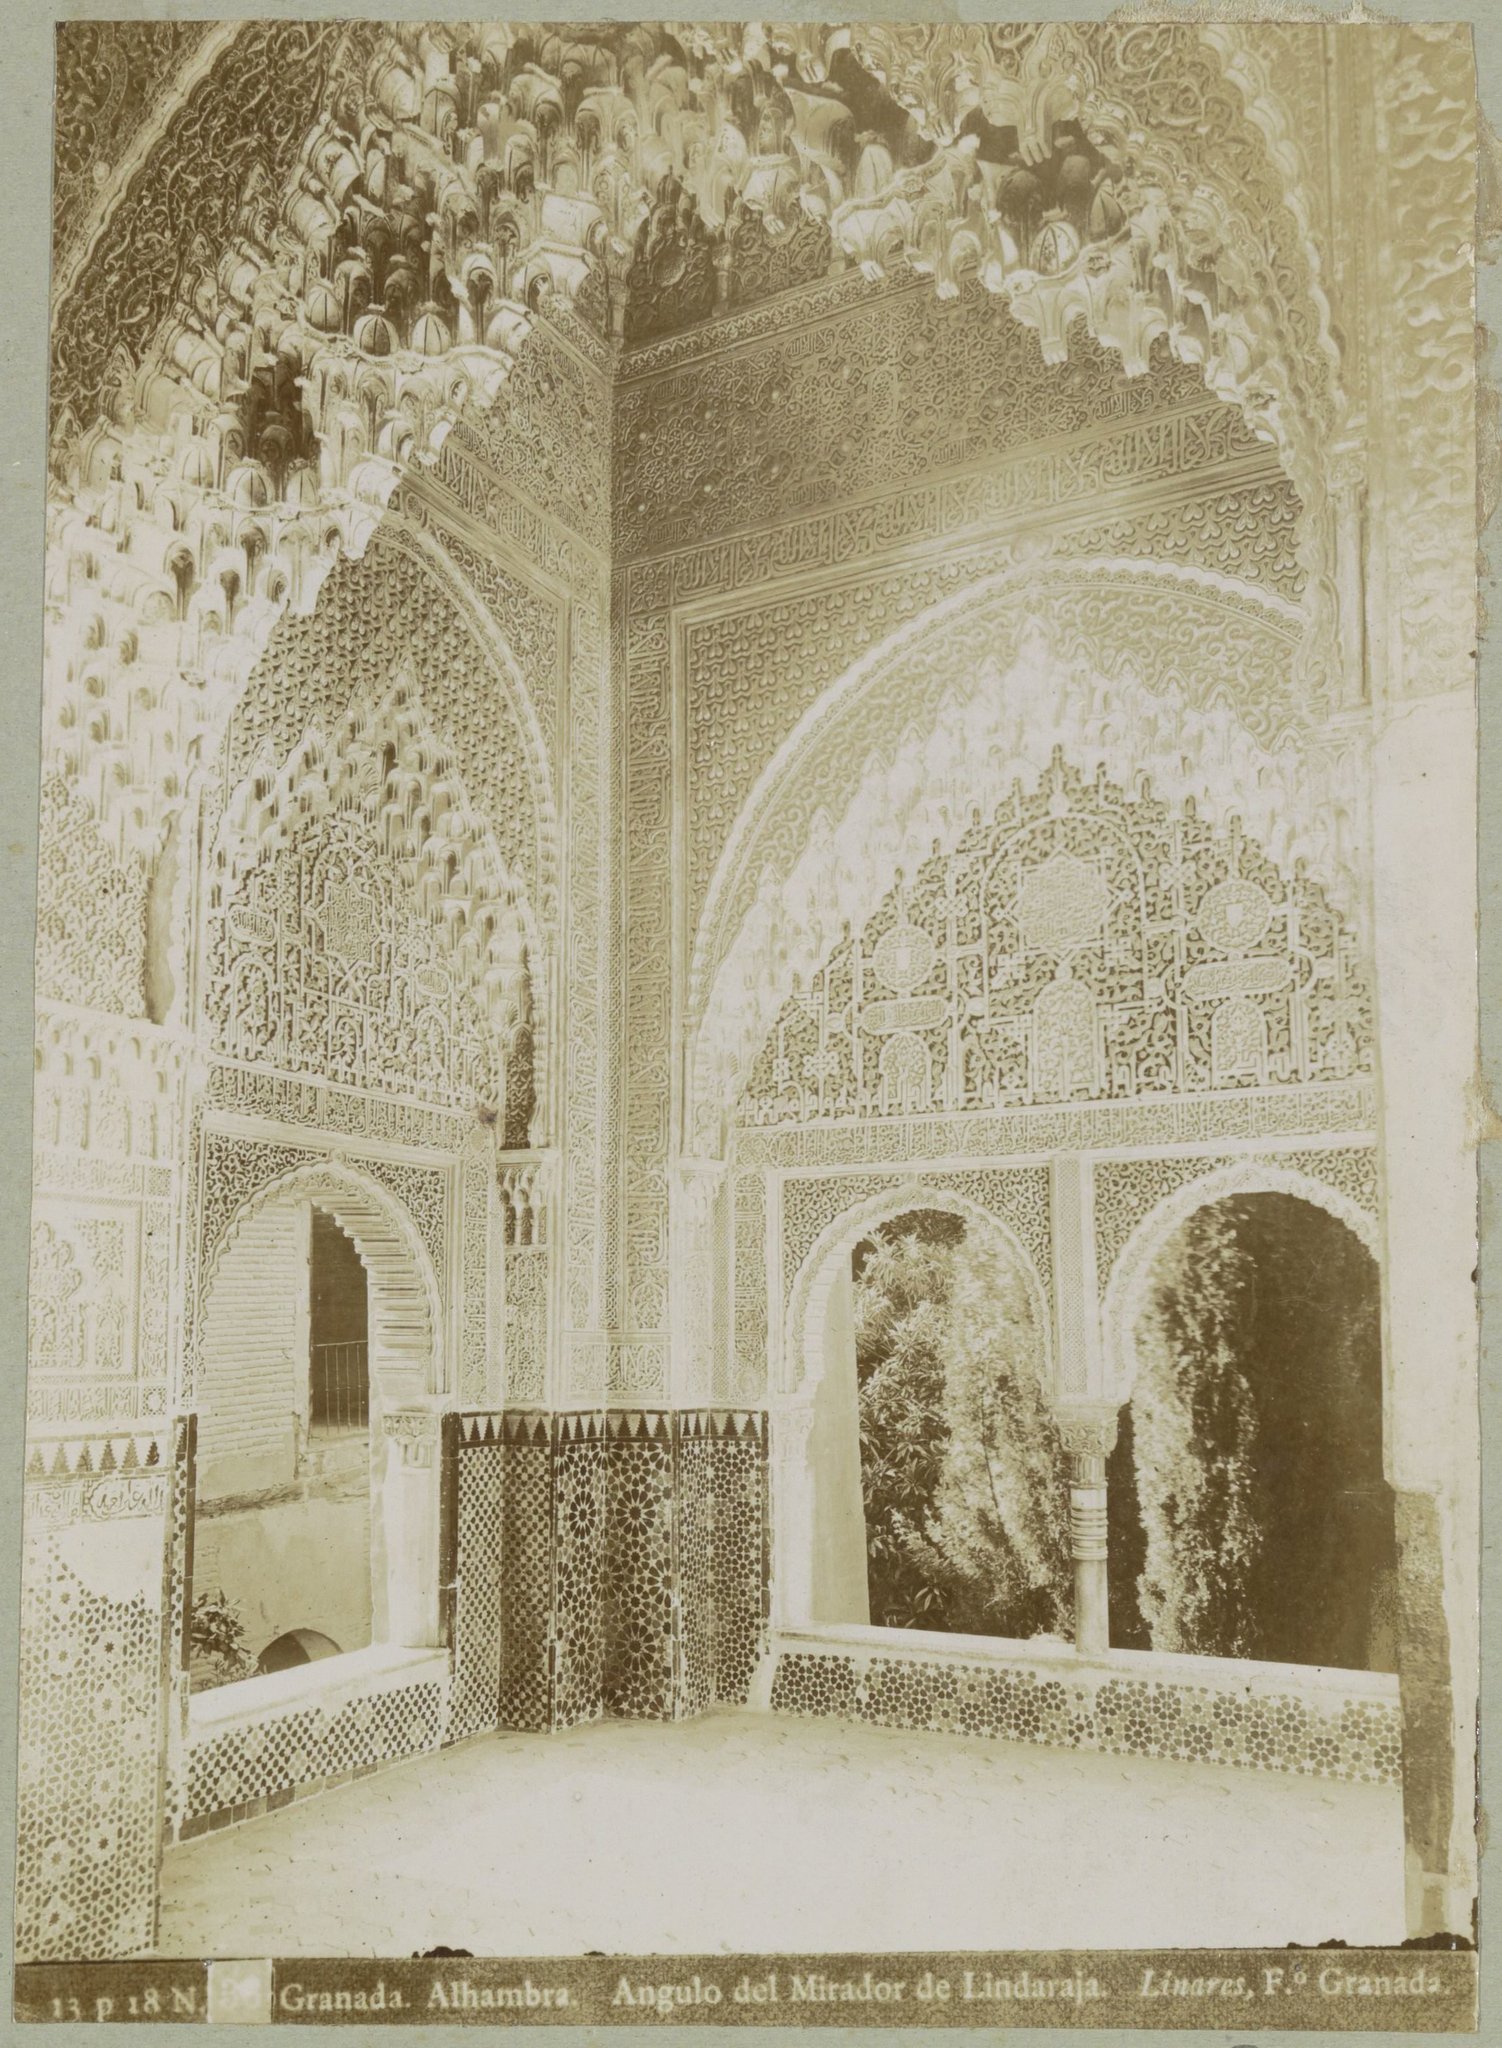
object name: photograph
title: Angulo del Mirador de Lindaraja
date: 1860-1900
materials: photographic support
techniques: daylight paper print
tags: fortress, palace, stuccoeing, sculpture (+ relief ~ sculpture)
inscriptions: number: ‘36’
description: Onderdeel van Reisalbum met opnames van het Alhambra in Granada.